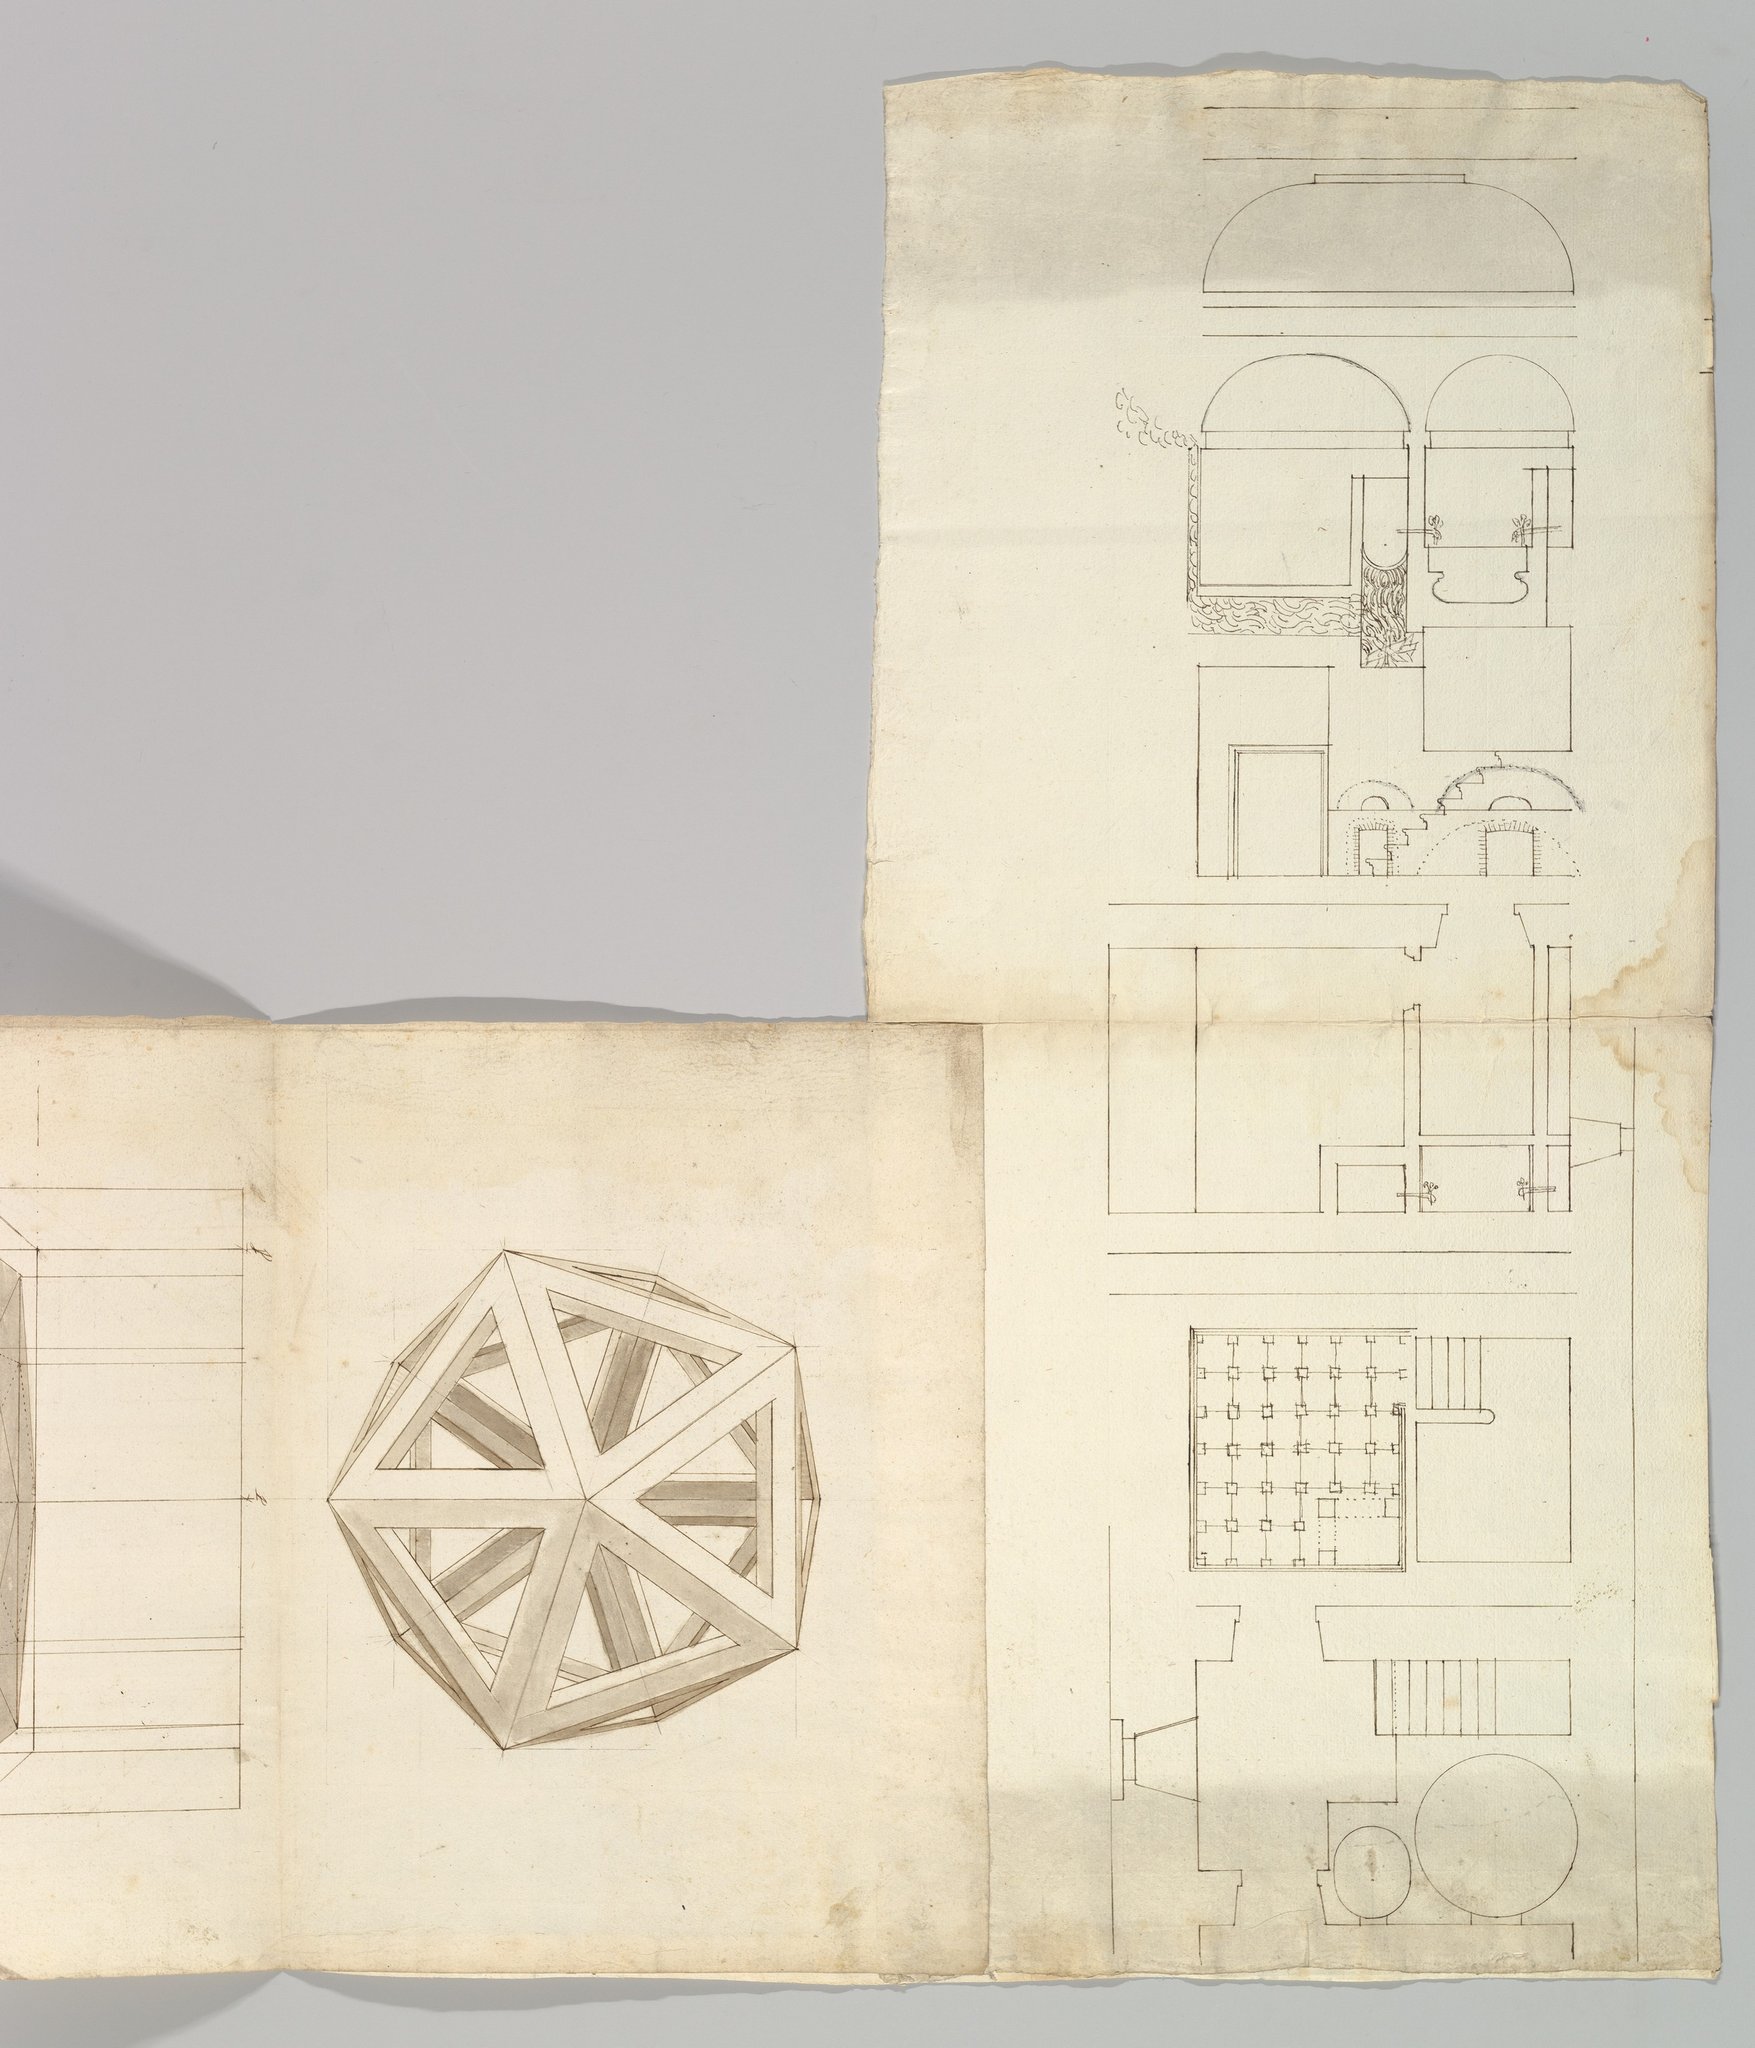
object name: drawing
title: Unidentified , orthographic study, plans and section (recto) Rhomicuboctahedron, skeletal, perspective; elevation, perspective projection (verso)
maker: anonymous, french, 16th century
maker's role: draftsman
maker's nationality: french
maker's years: 1500-1600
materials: chalk, ink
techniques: incising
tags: architecture